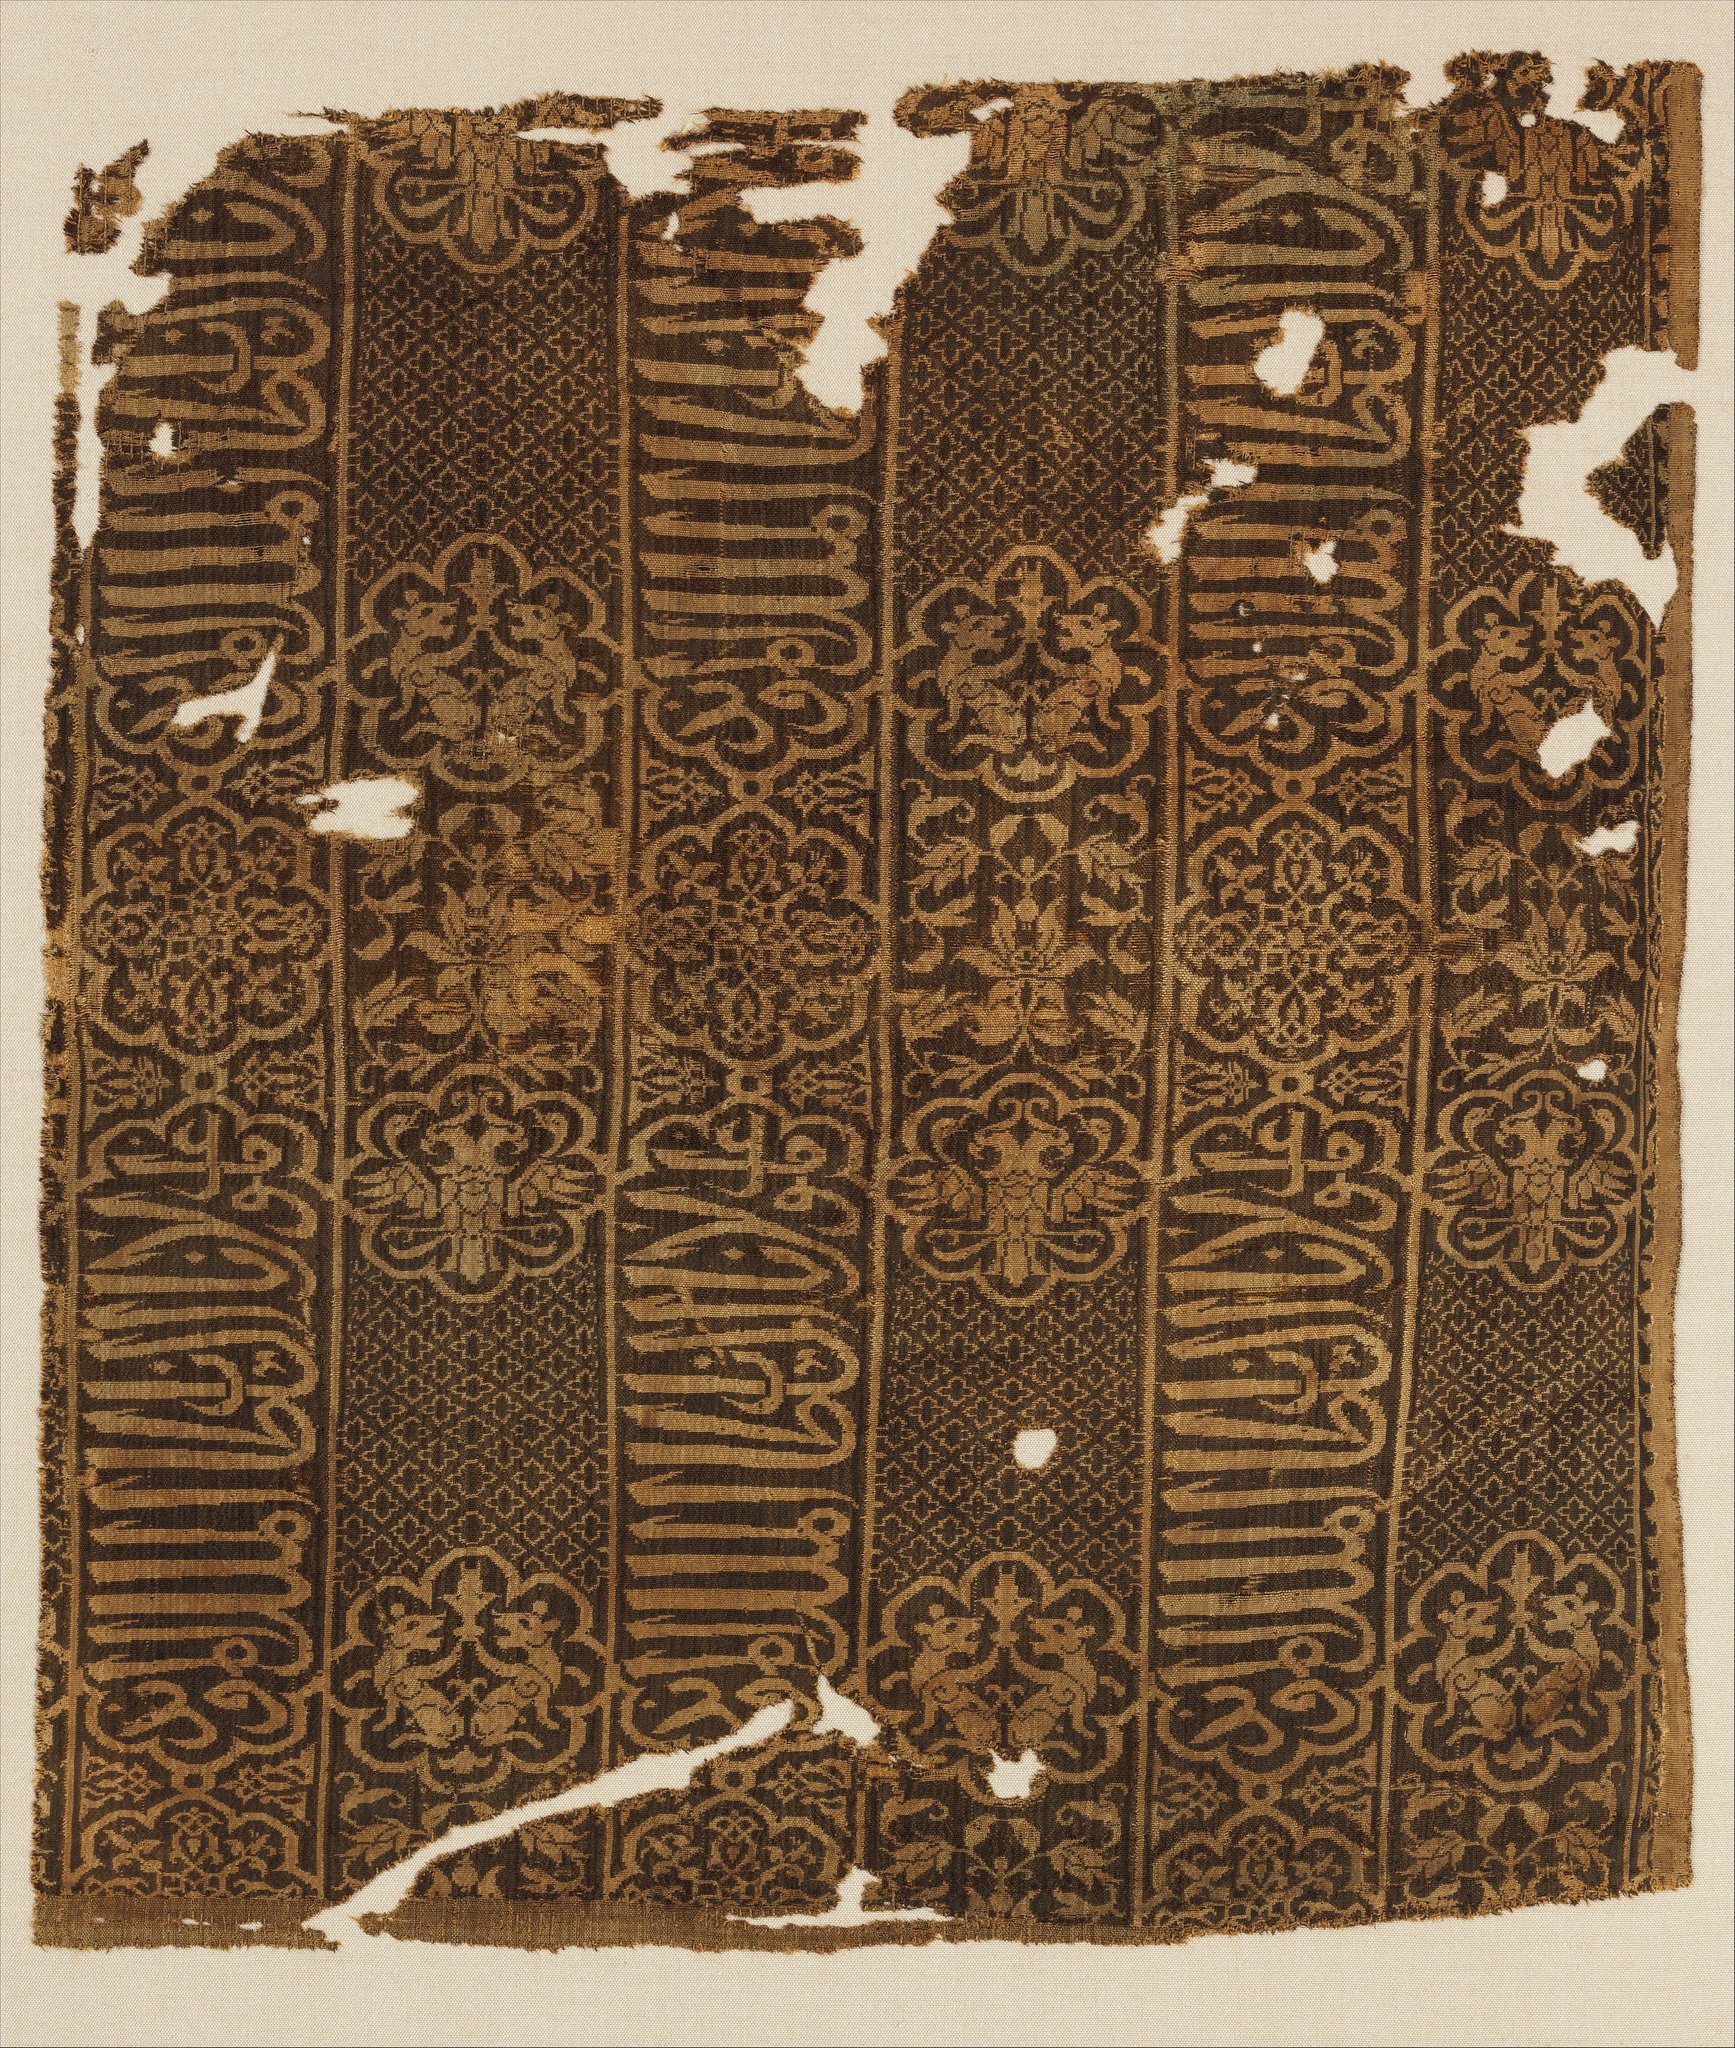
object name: fragment of a coat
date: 1301-1333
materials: silk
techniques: weave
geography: egypt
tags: arabic